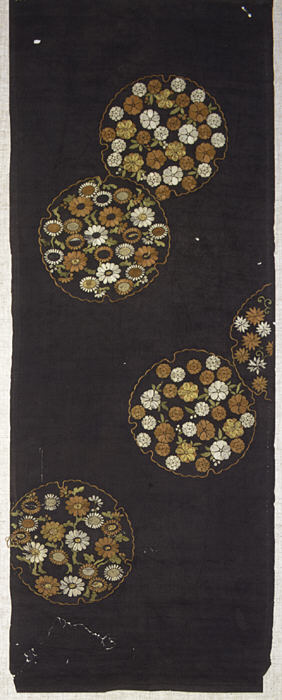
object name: piece from a kosode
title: Piece from a Kosode with Pattern of Scattered Snow Roundels (Yukiwa) Filled with Small Flowers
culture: japanese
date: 1601-1700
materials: metal thread, silk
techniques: embroidery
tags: flowers